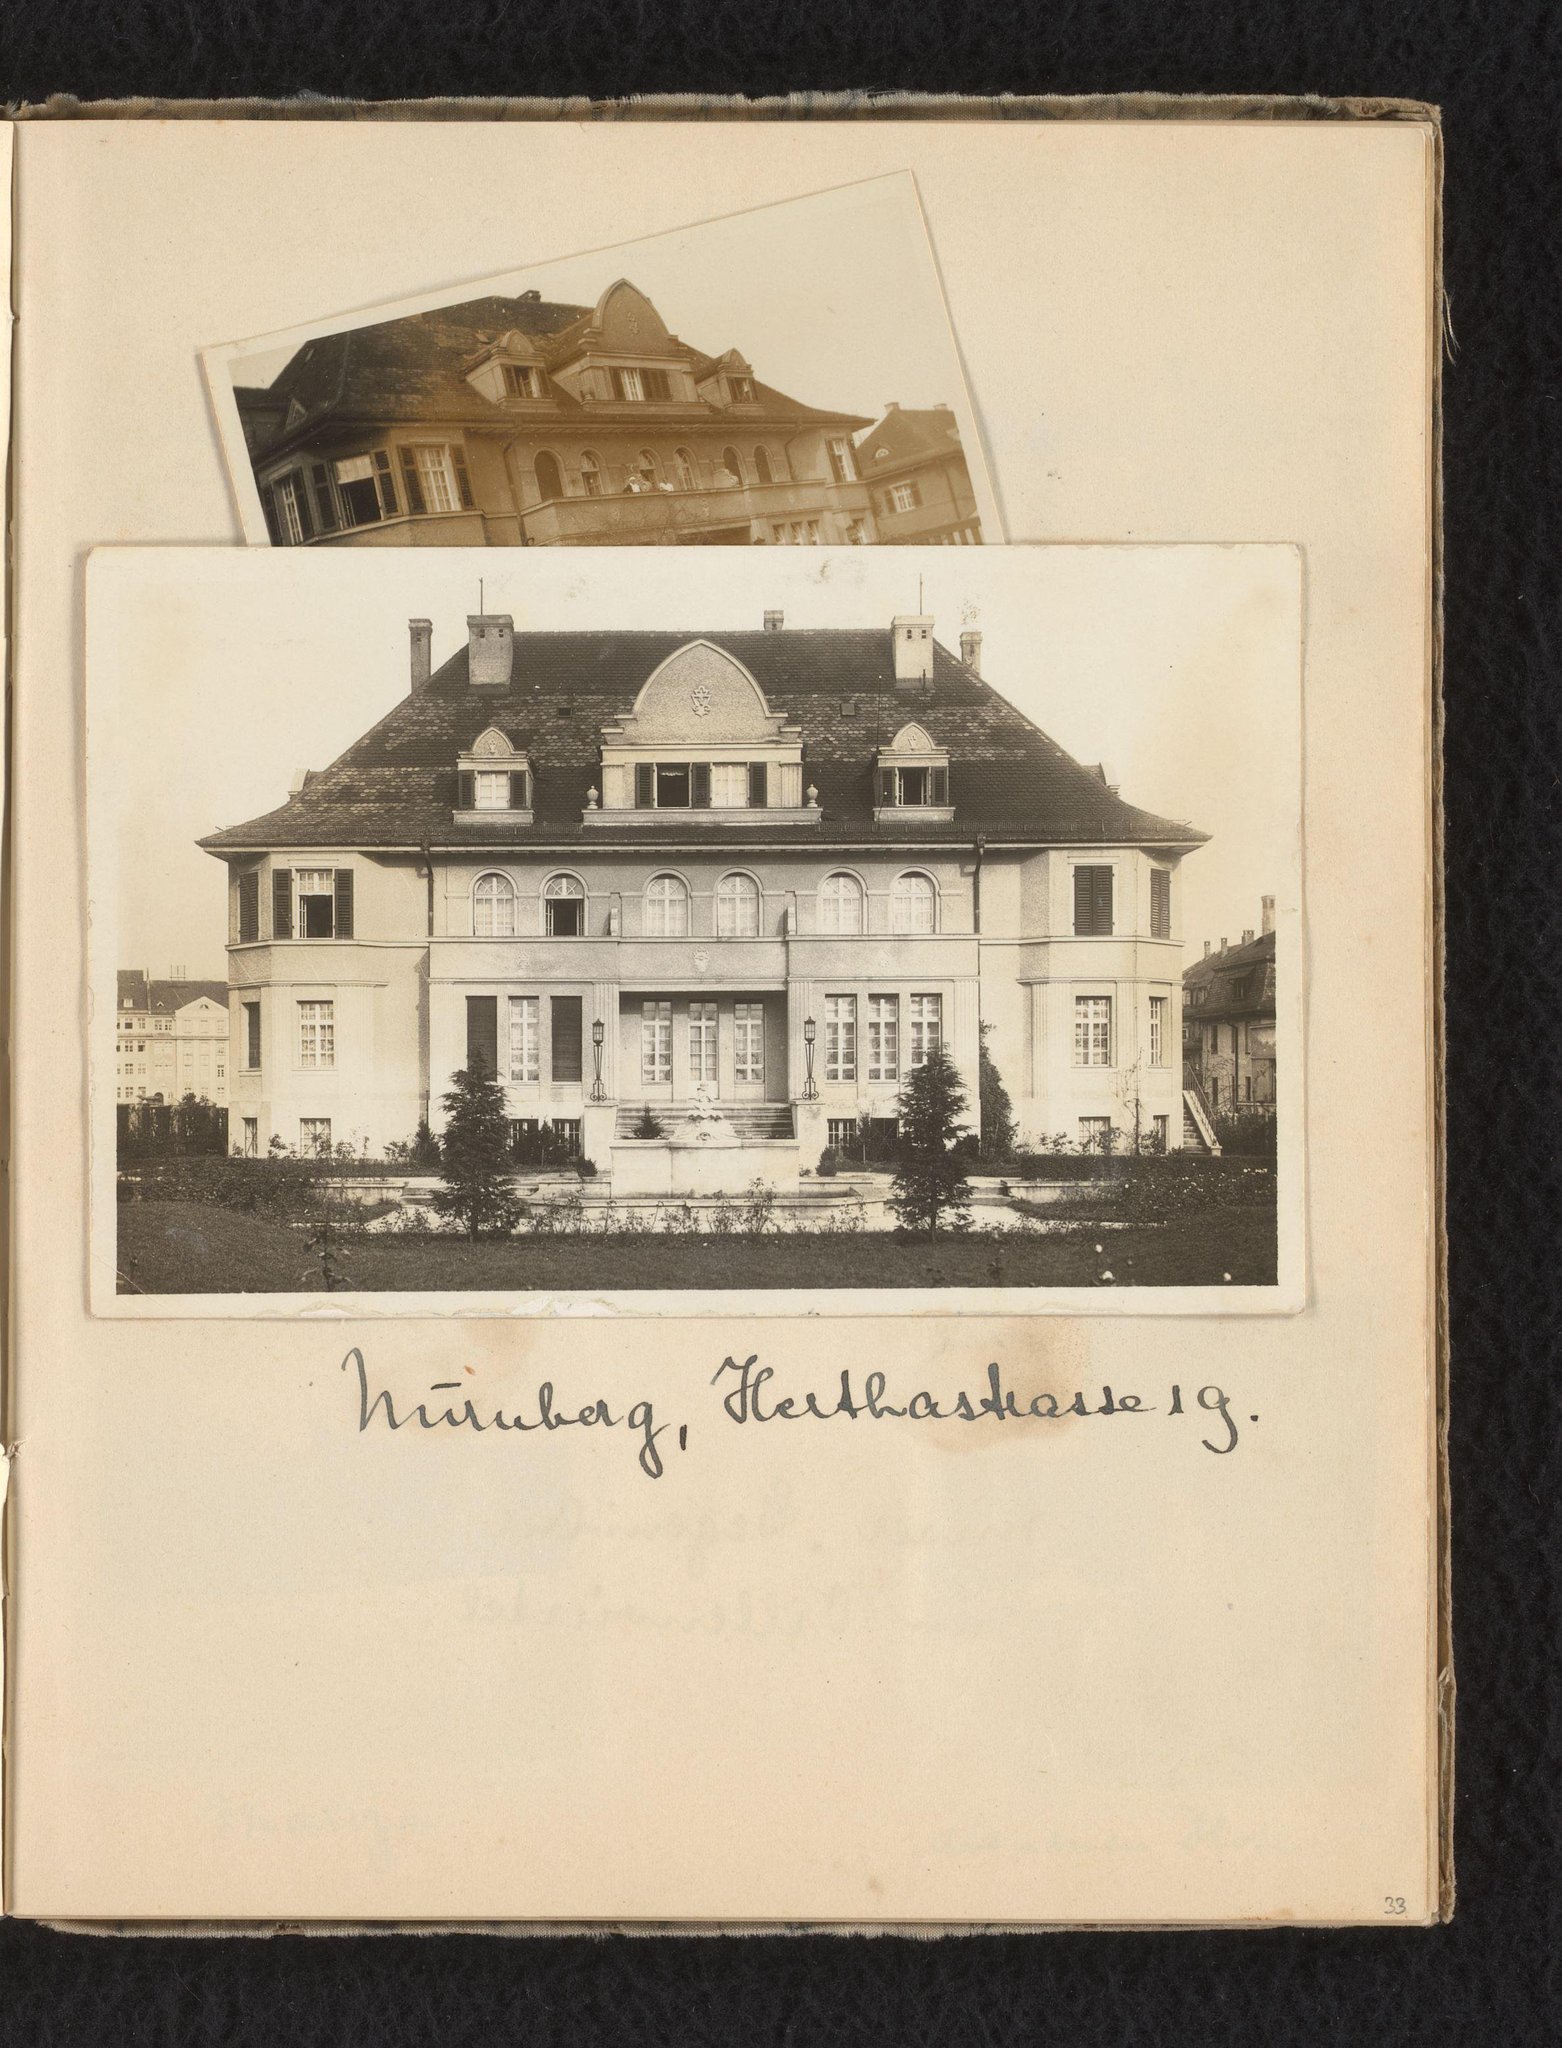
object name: photograph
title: Vooraanzicht van de woning van Eugen Wachenheimer en zijn echtgenote Else Wachenheimer-Moos (Herthastrasse 19), 1928, Neurenberg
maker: else wachenheimer-moos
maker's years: 1895-1944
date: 1928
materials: paper, photographic support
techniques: gelatin silver print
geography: nuremberg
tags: detached house in city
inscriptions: inscription: ‘Nürnberg, Herthastrasse 19.’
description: Blad bevat twee foto's van Herthastrasse 19, eentje ingeplakt, eentje los. Onderdeel van het fotoalbum van de reizen die Eugen en Else Wachenheimer jaarlijks maakten rondom de viering van hun huwelijksdag en verloving.